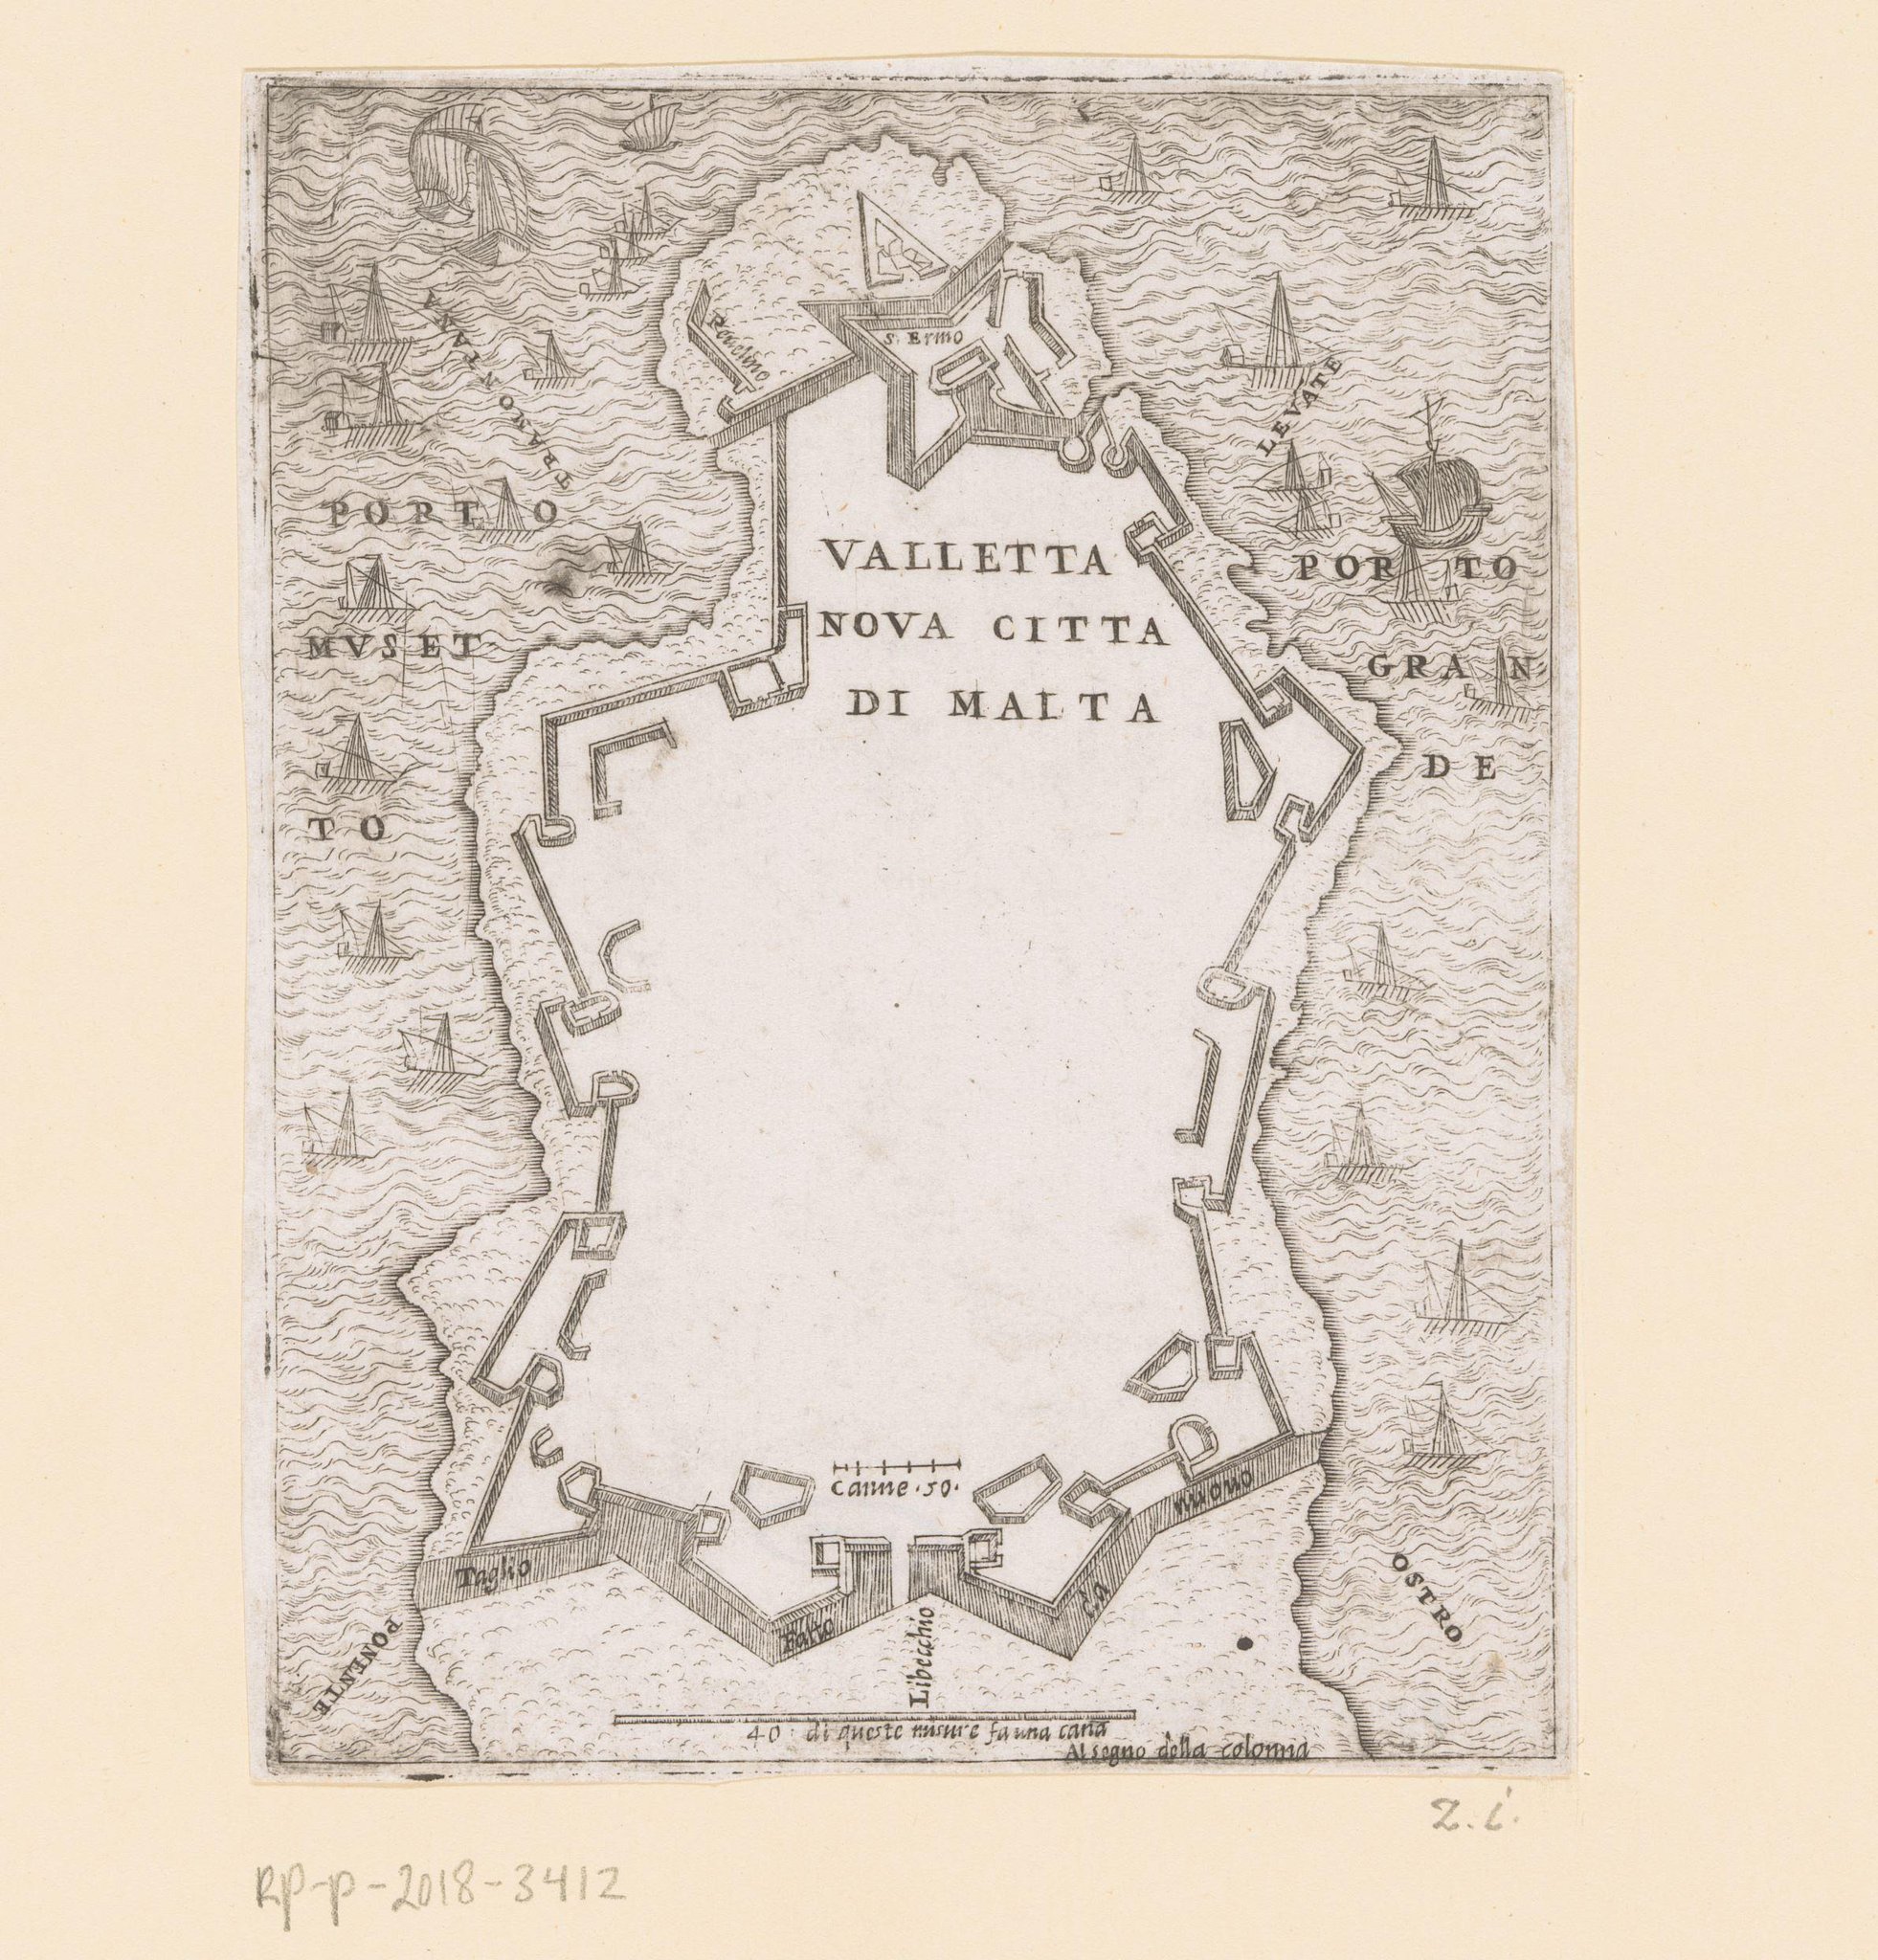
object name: area plan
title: Vestingplattegrond van Valletta op Malta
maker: Anonymous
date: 1550-1650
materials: paper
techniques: etching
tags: island, maps, atlases, fortified city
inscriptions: collector's mark: Lugt 2228